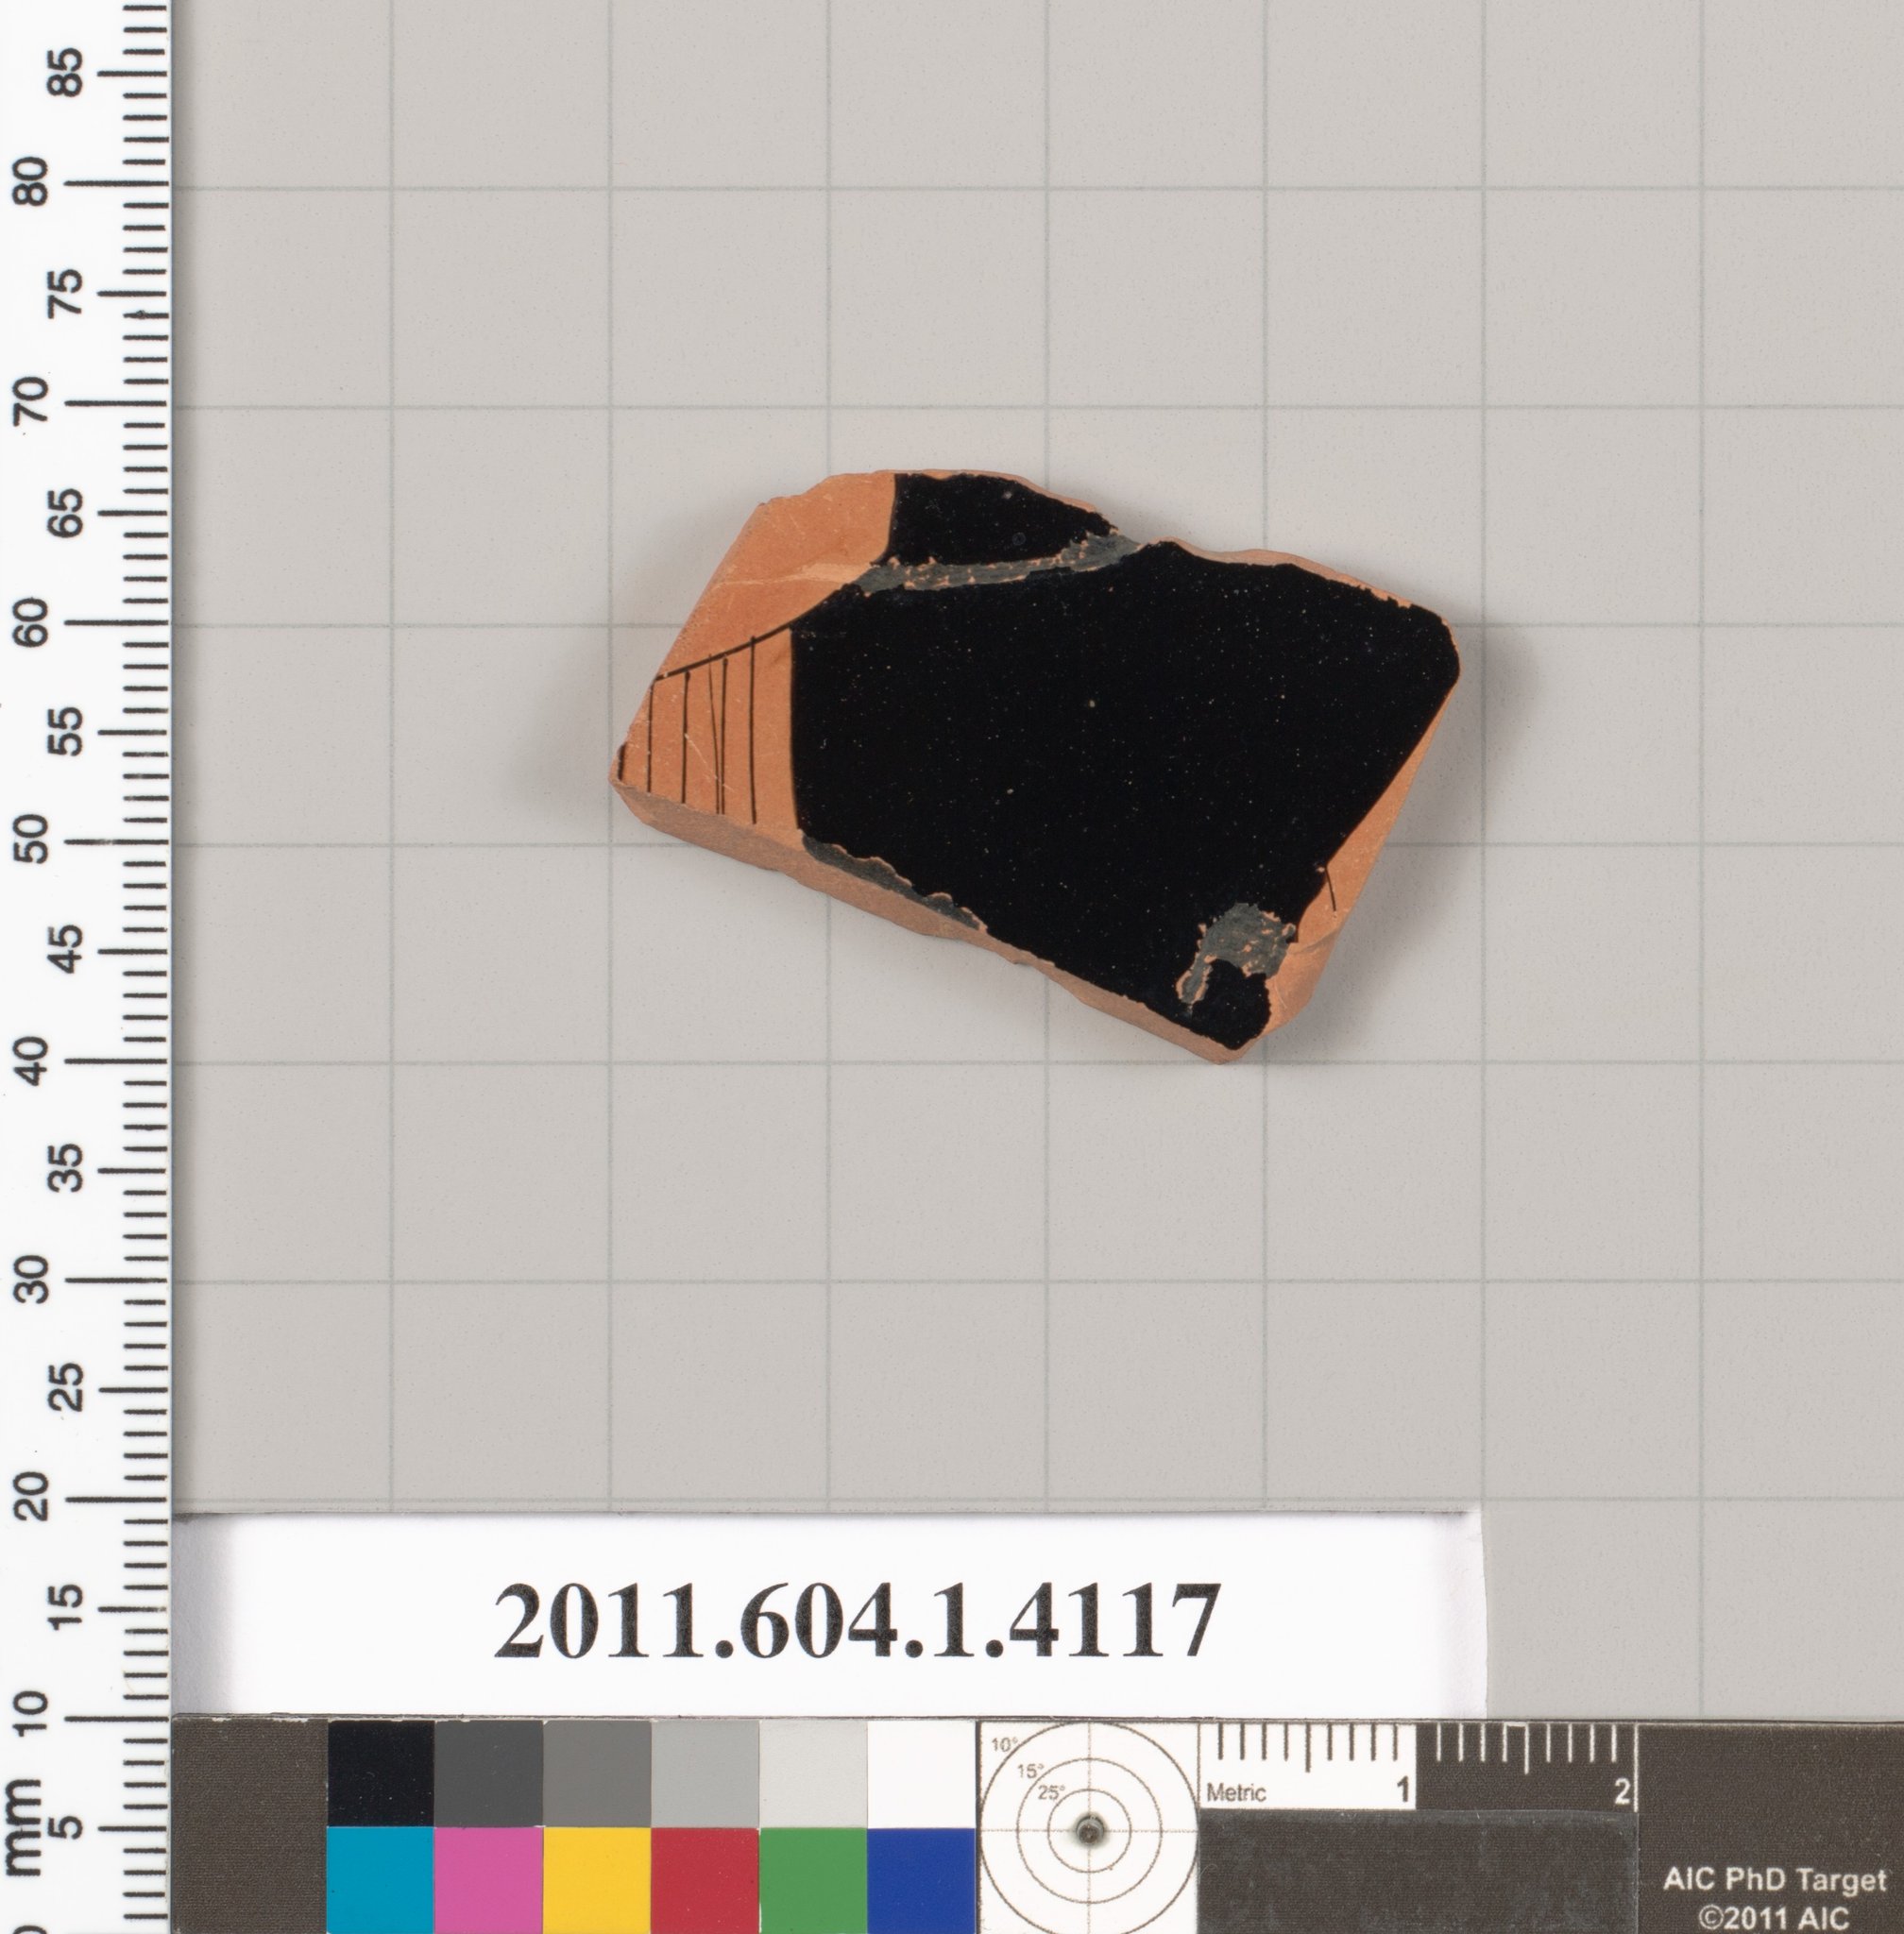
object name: kylix fragment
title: Terracotta fragment of a kylix (drinking cup)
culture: greek, attic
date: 490-470 BCE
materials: terracotta